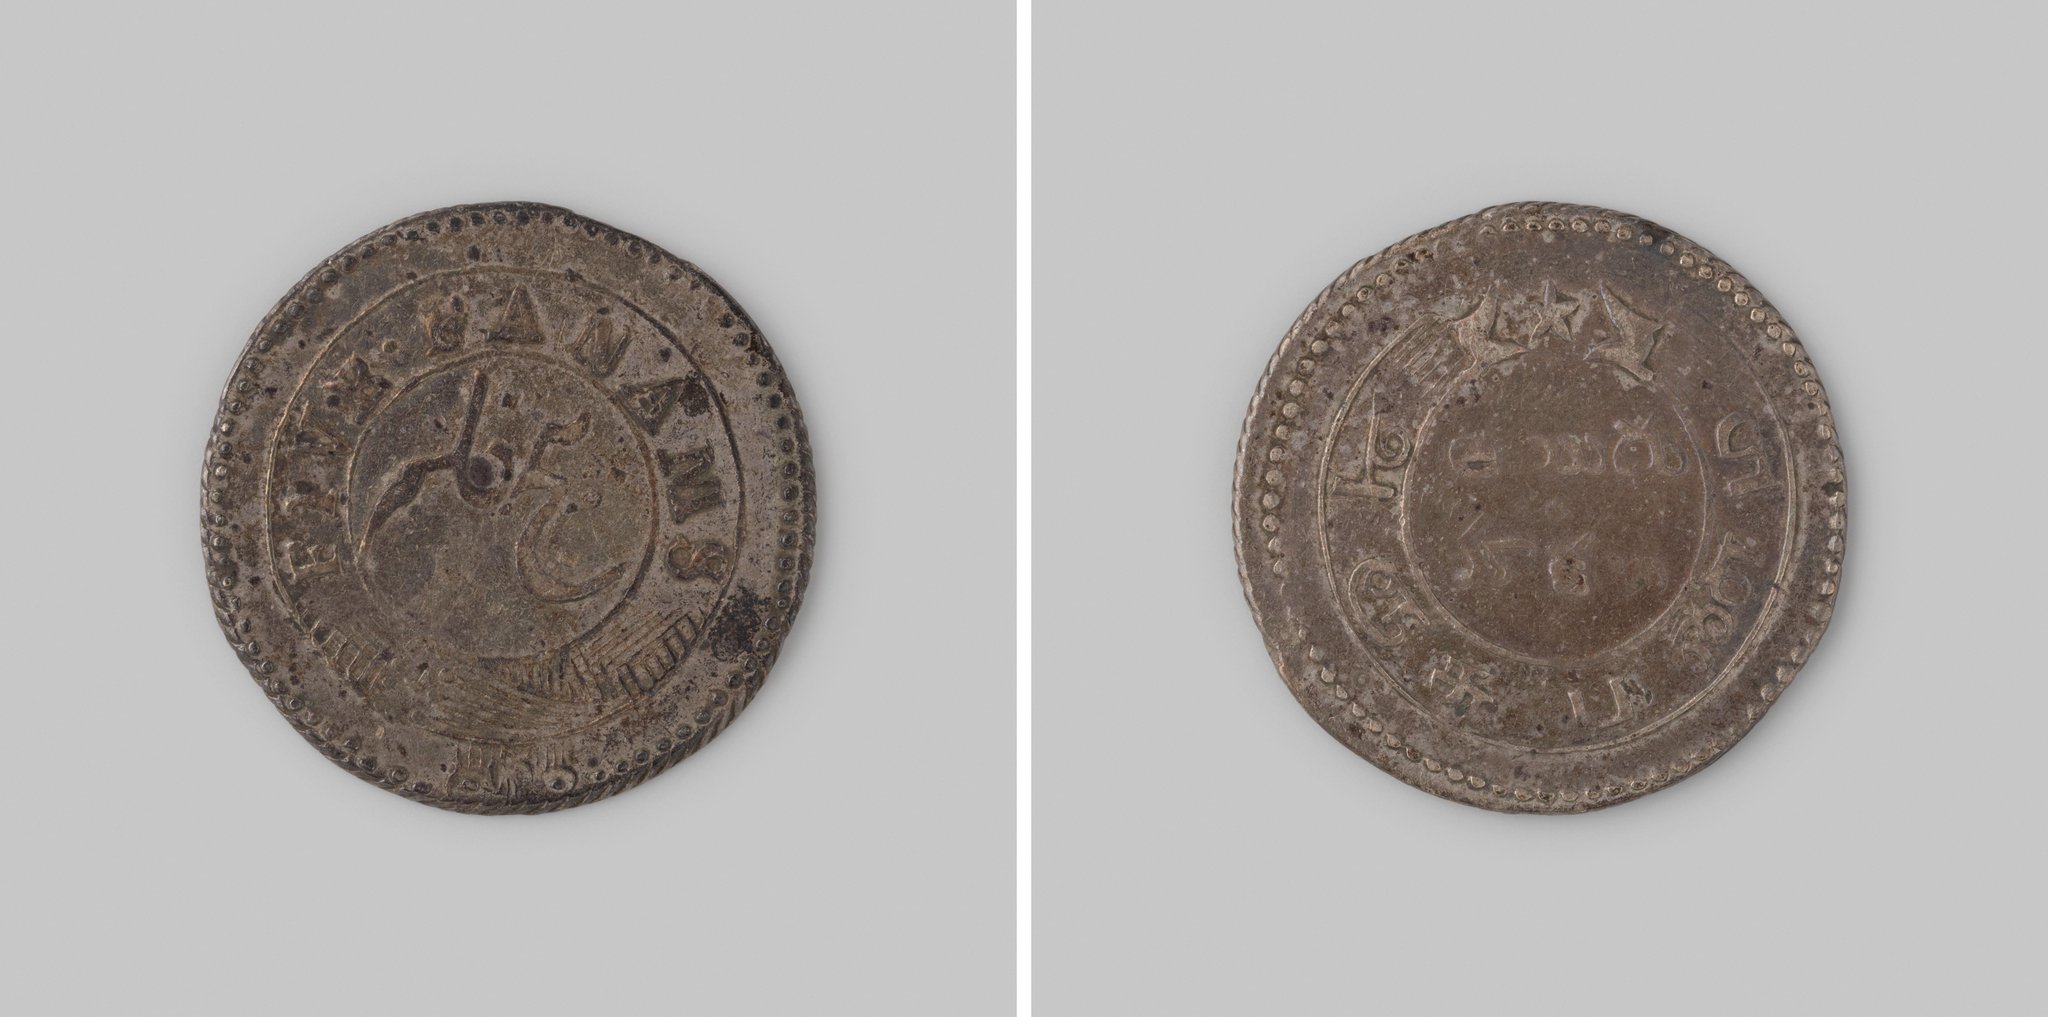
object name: coin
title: 5 fanams voor Madras in India van de Engelse Oostindische Compagnie (EIC), (1808)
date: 1808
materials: silver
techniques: striking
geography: chennai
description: Zilveren munt. Voorzijde: binnen cirkel, gevormd door ceintuur met gesp, waarde-aanduiding in het Engels: five fanams, op een regel waarde-aanduiding in Arabische lettertekens. Keerzijde: binnen cirkel, gevormd door lint, waarop waarde-aanduiding in het Tamil, in twee regels waarde-aanduiding in het Telugu. Bovenaan, tussen uiteinden van het lint, een ster. Kabelrand.